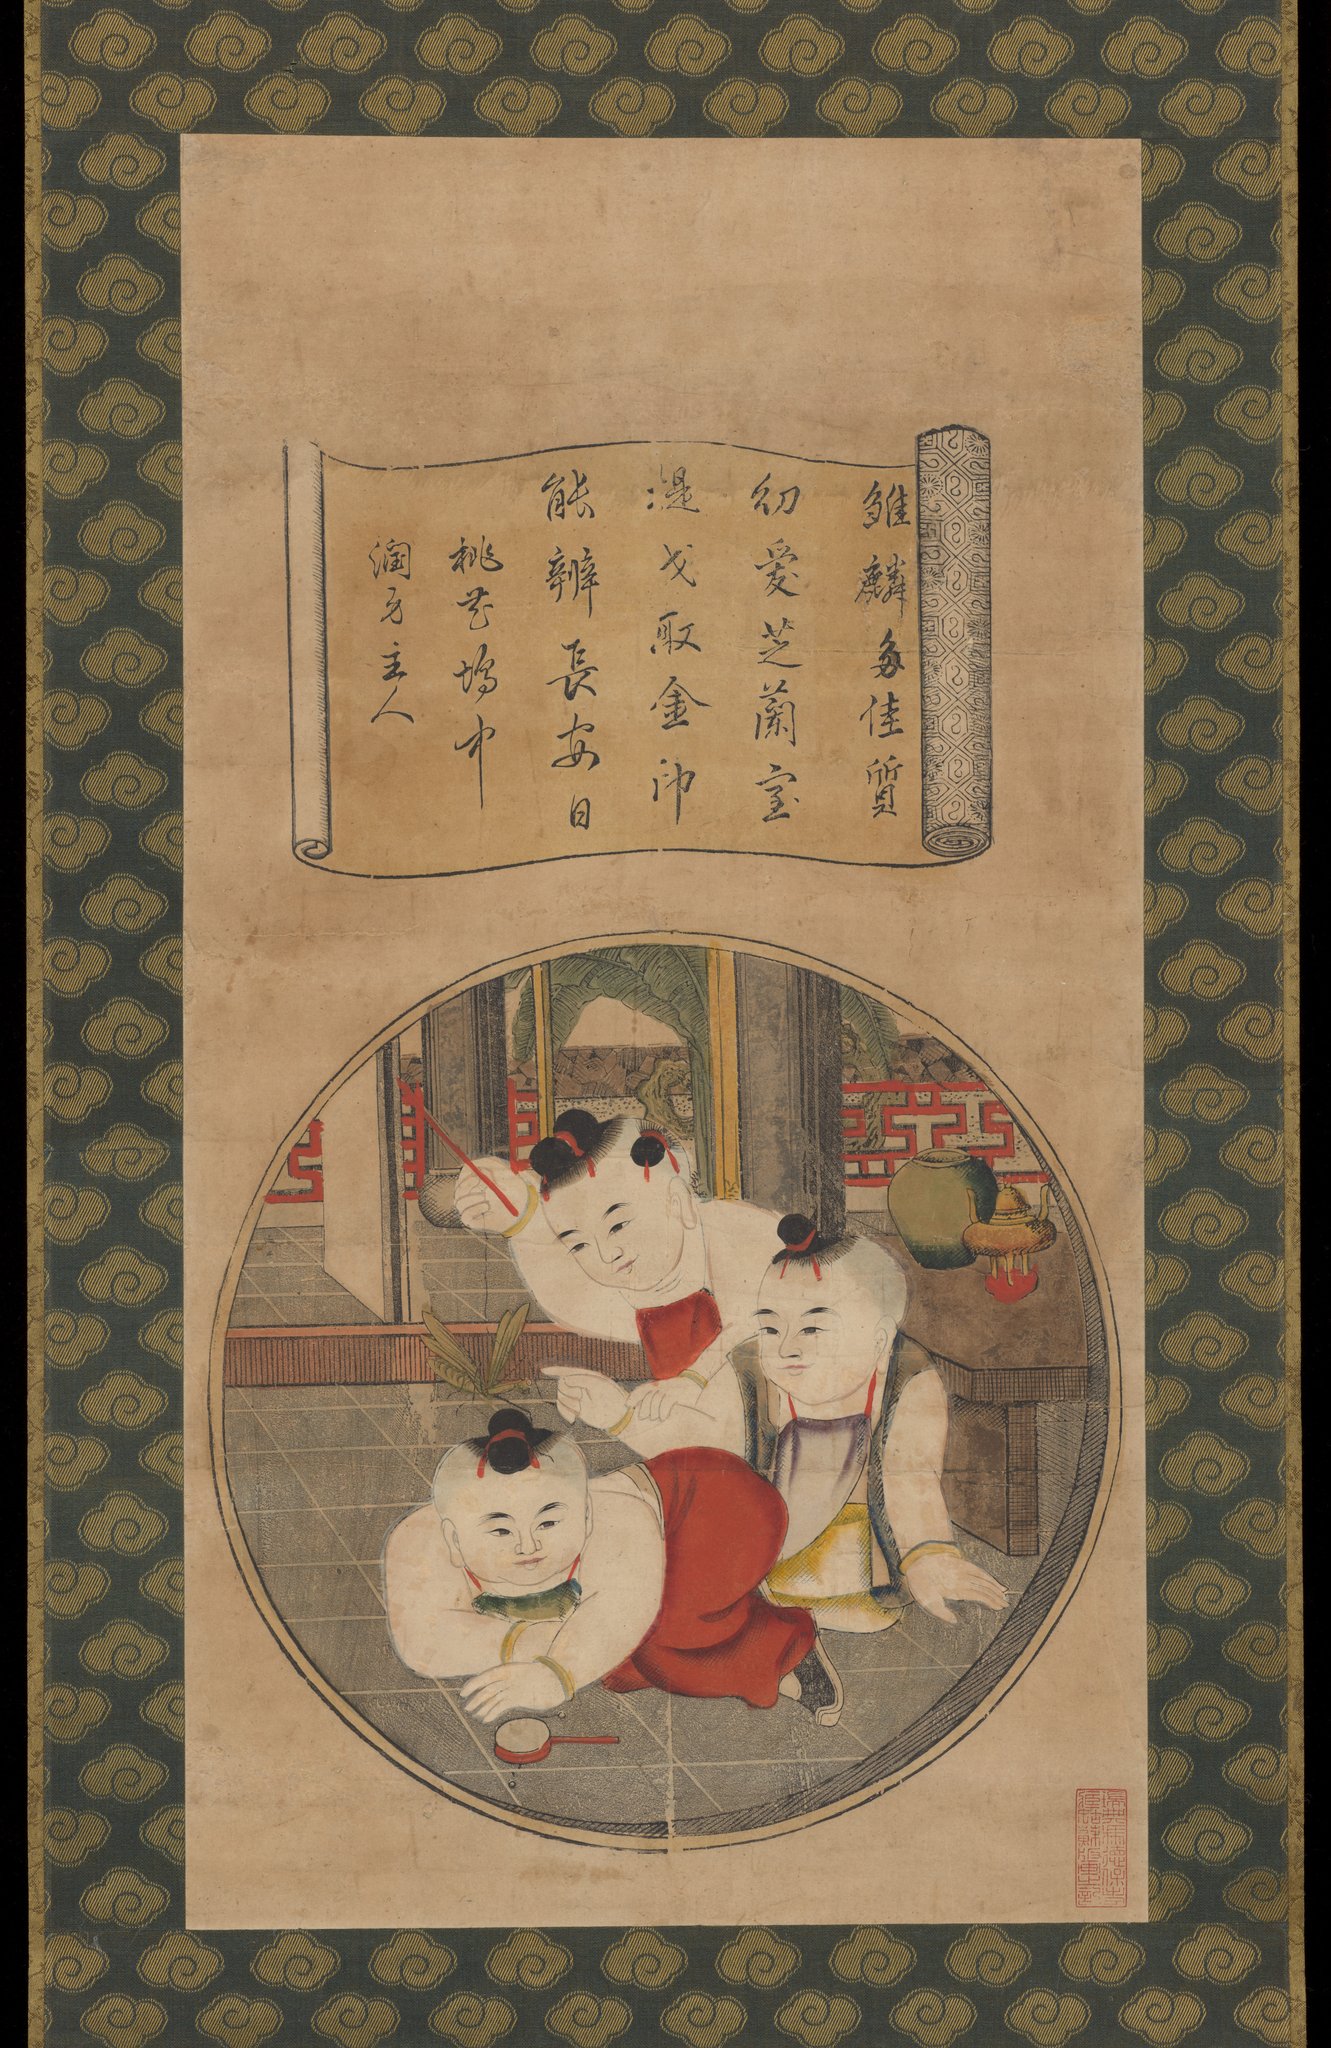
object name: print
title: Praying Mantis and Three Toddlers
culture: chinese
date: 1736-1795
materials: ink, paper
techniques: hand coloring, woodblock print